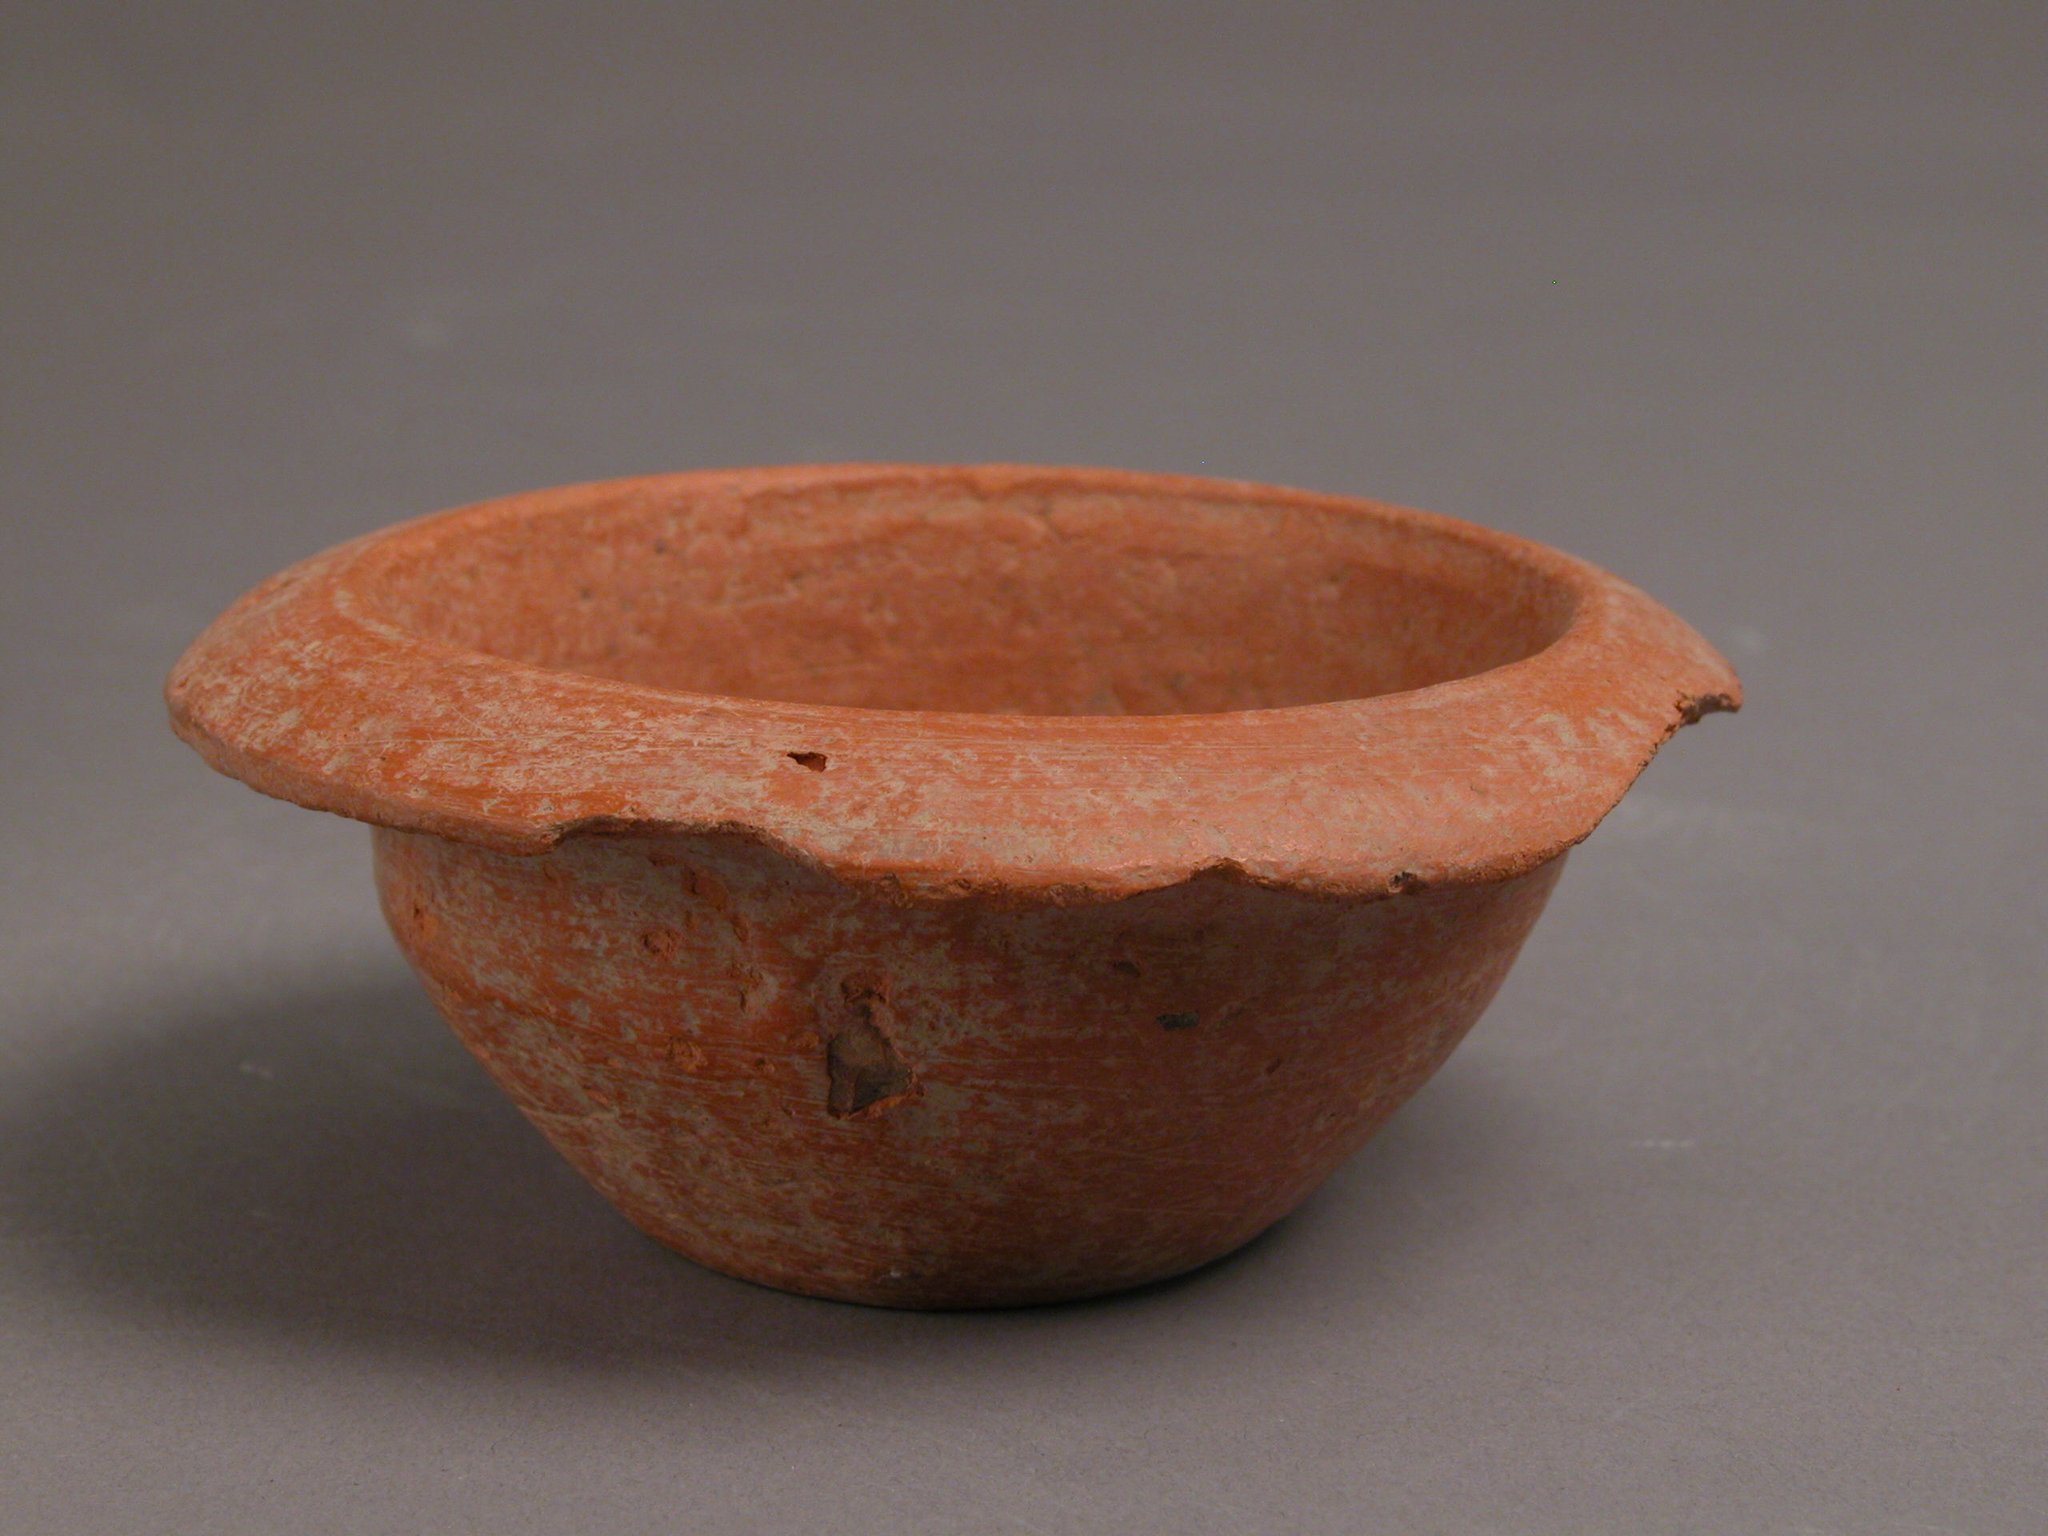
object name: bowl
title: Nesting Bowl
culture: coptic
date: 301-700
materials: earthenware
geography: egypt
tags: bowls